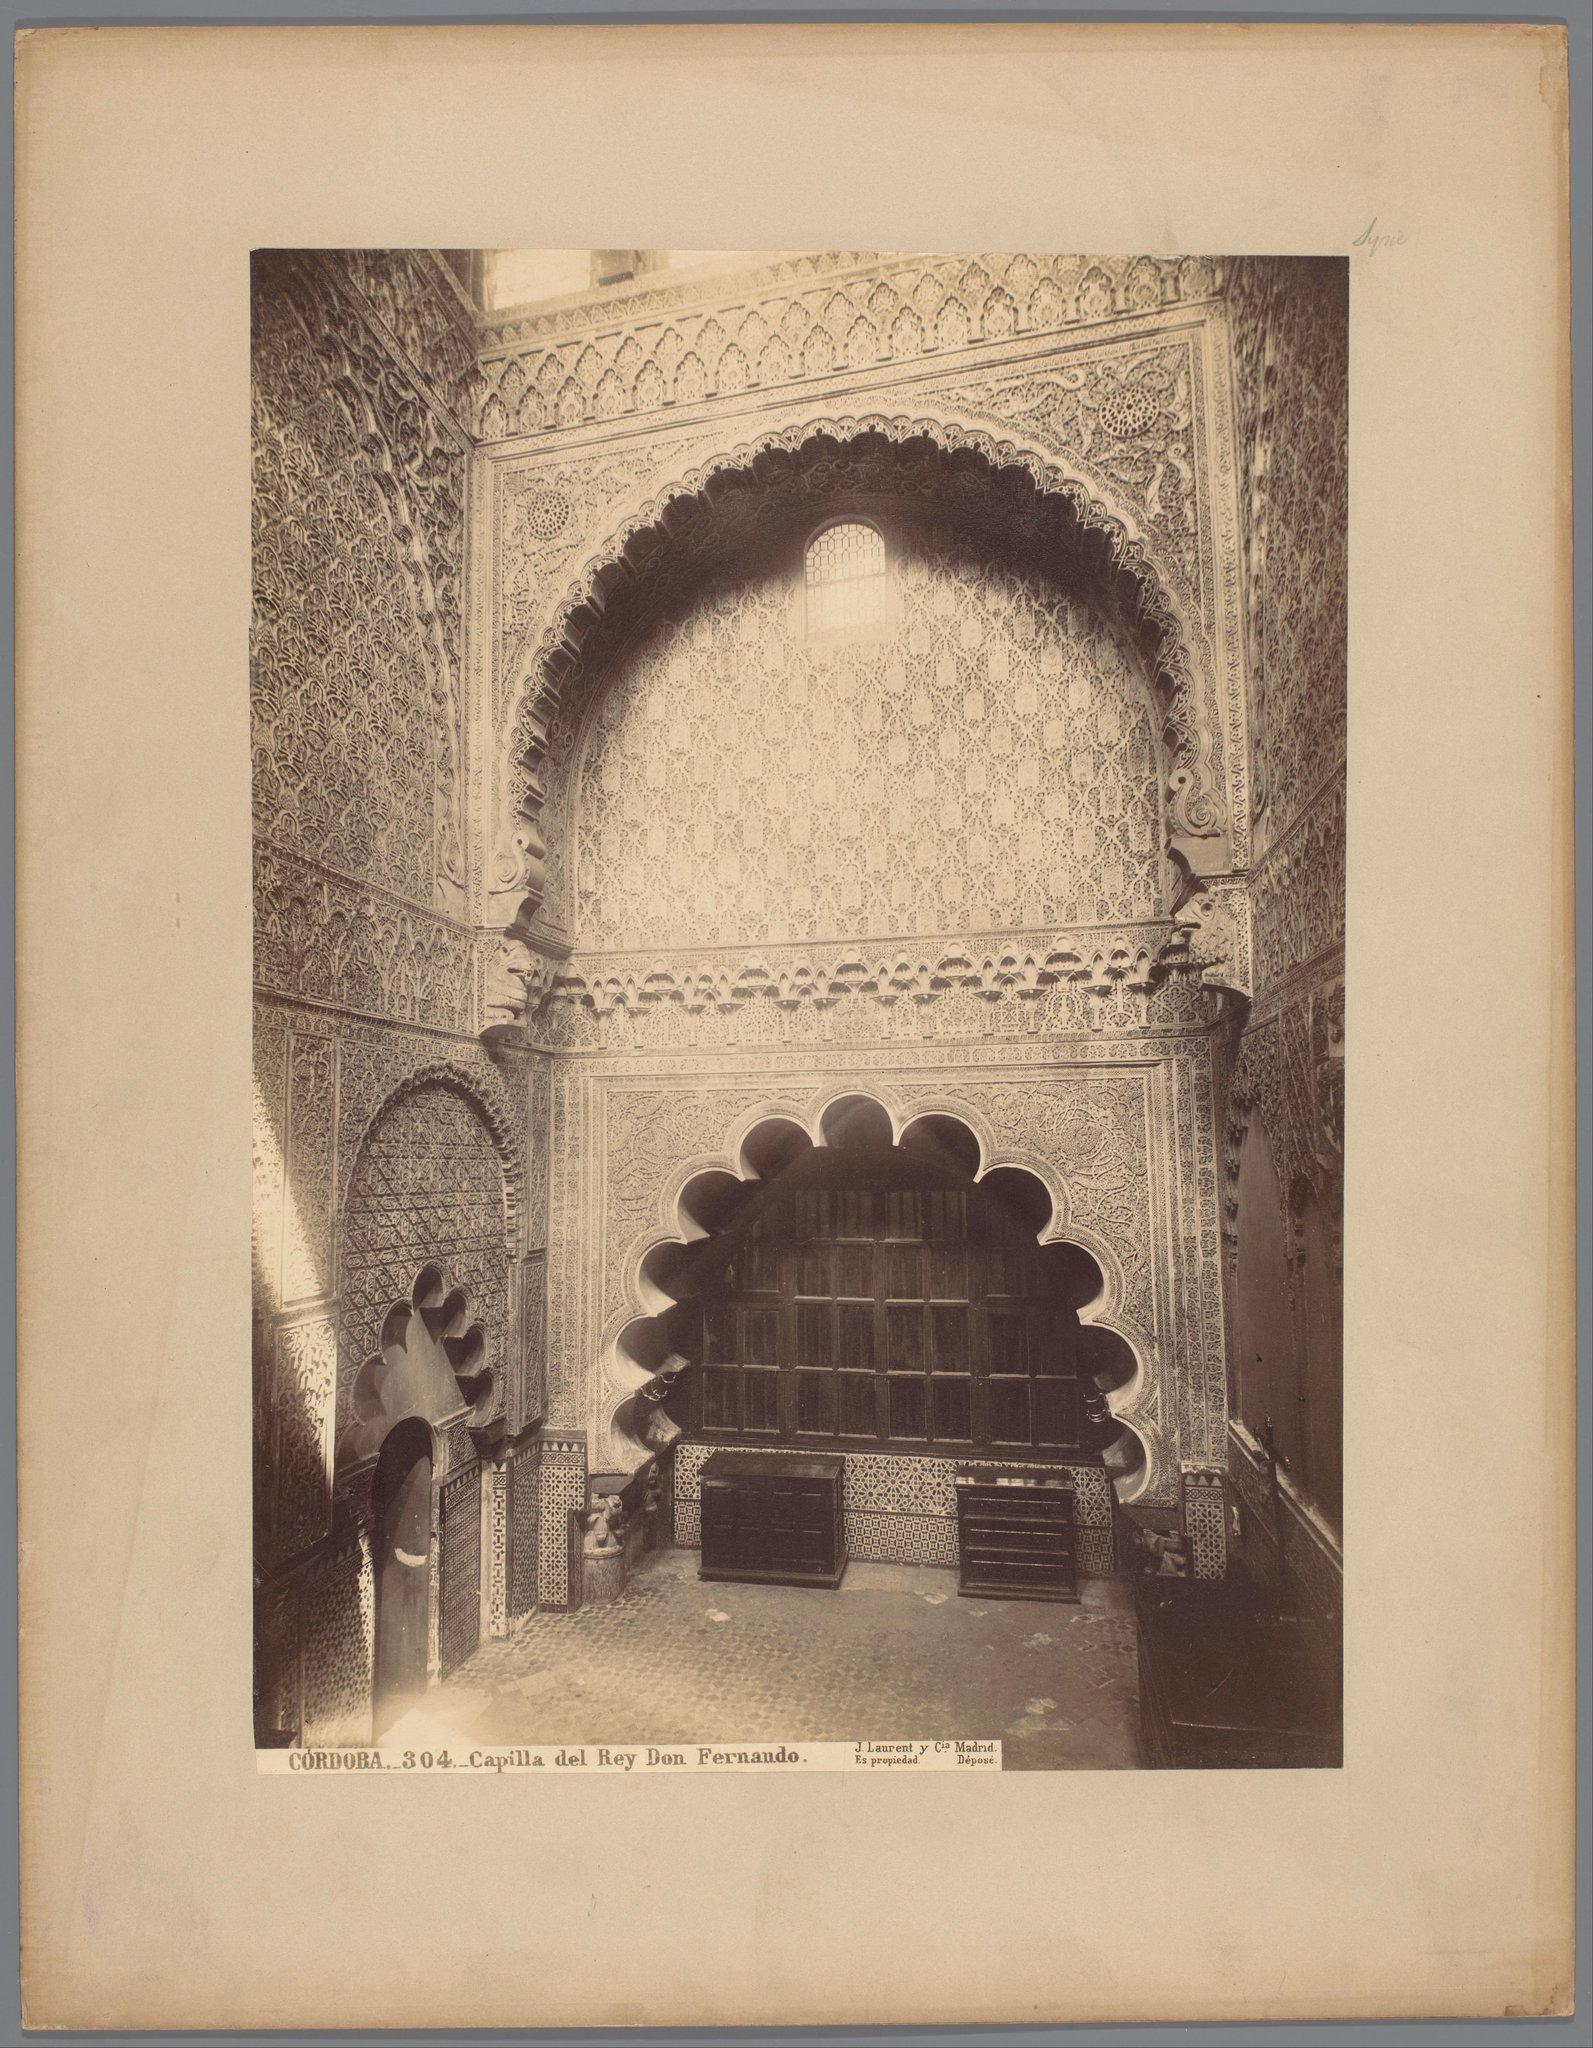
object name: photograph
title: CÓRDOBA. Capilla del Rey Don Fernando.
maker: juan laurent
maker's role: publisher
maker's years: 1816-1896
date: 1875-1900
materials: cardboard, photographic support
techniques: albumen print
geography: mezquita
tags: parts of church interior: chapel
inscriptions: collector's mark: Lugt 3937, number: ‘304.’